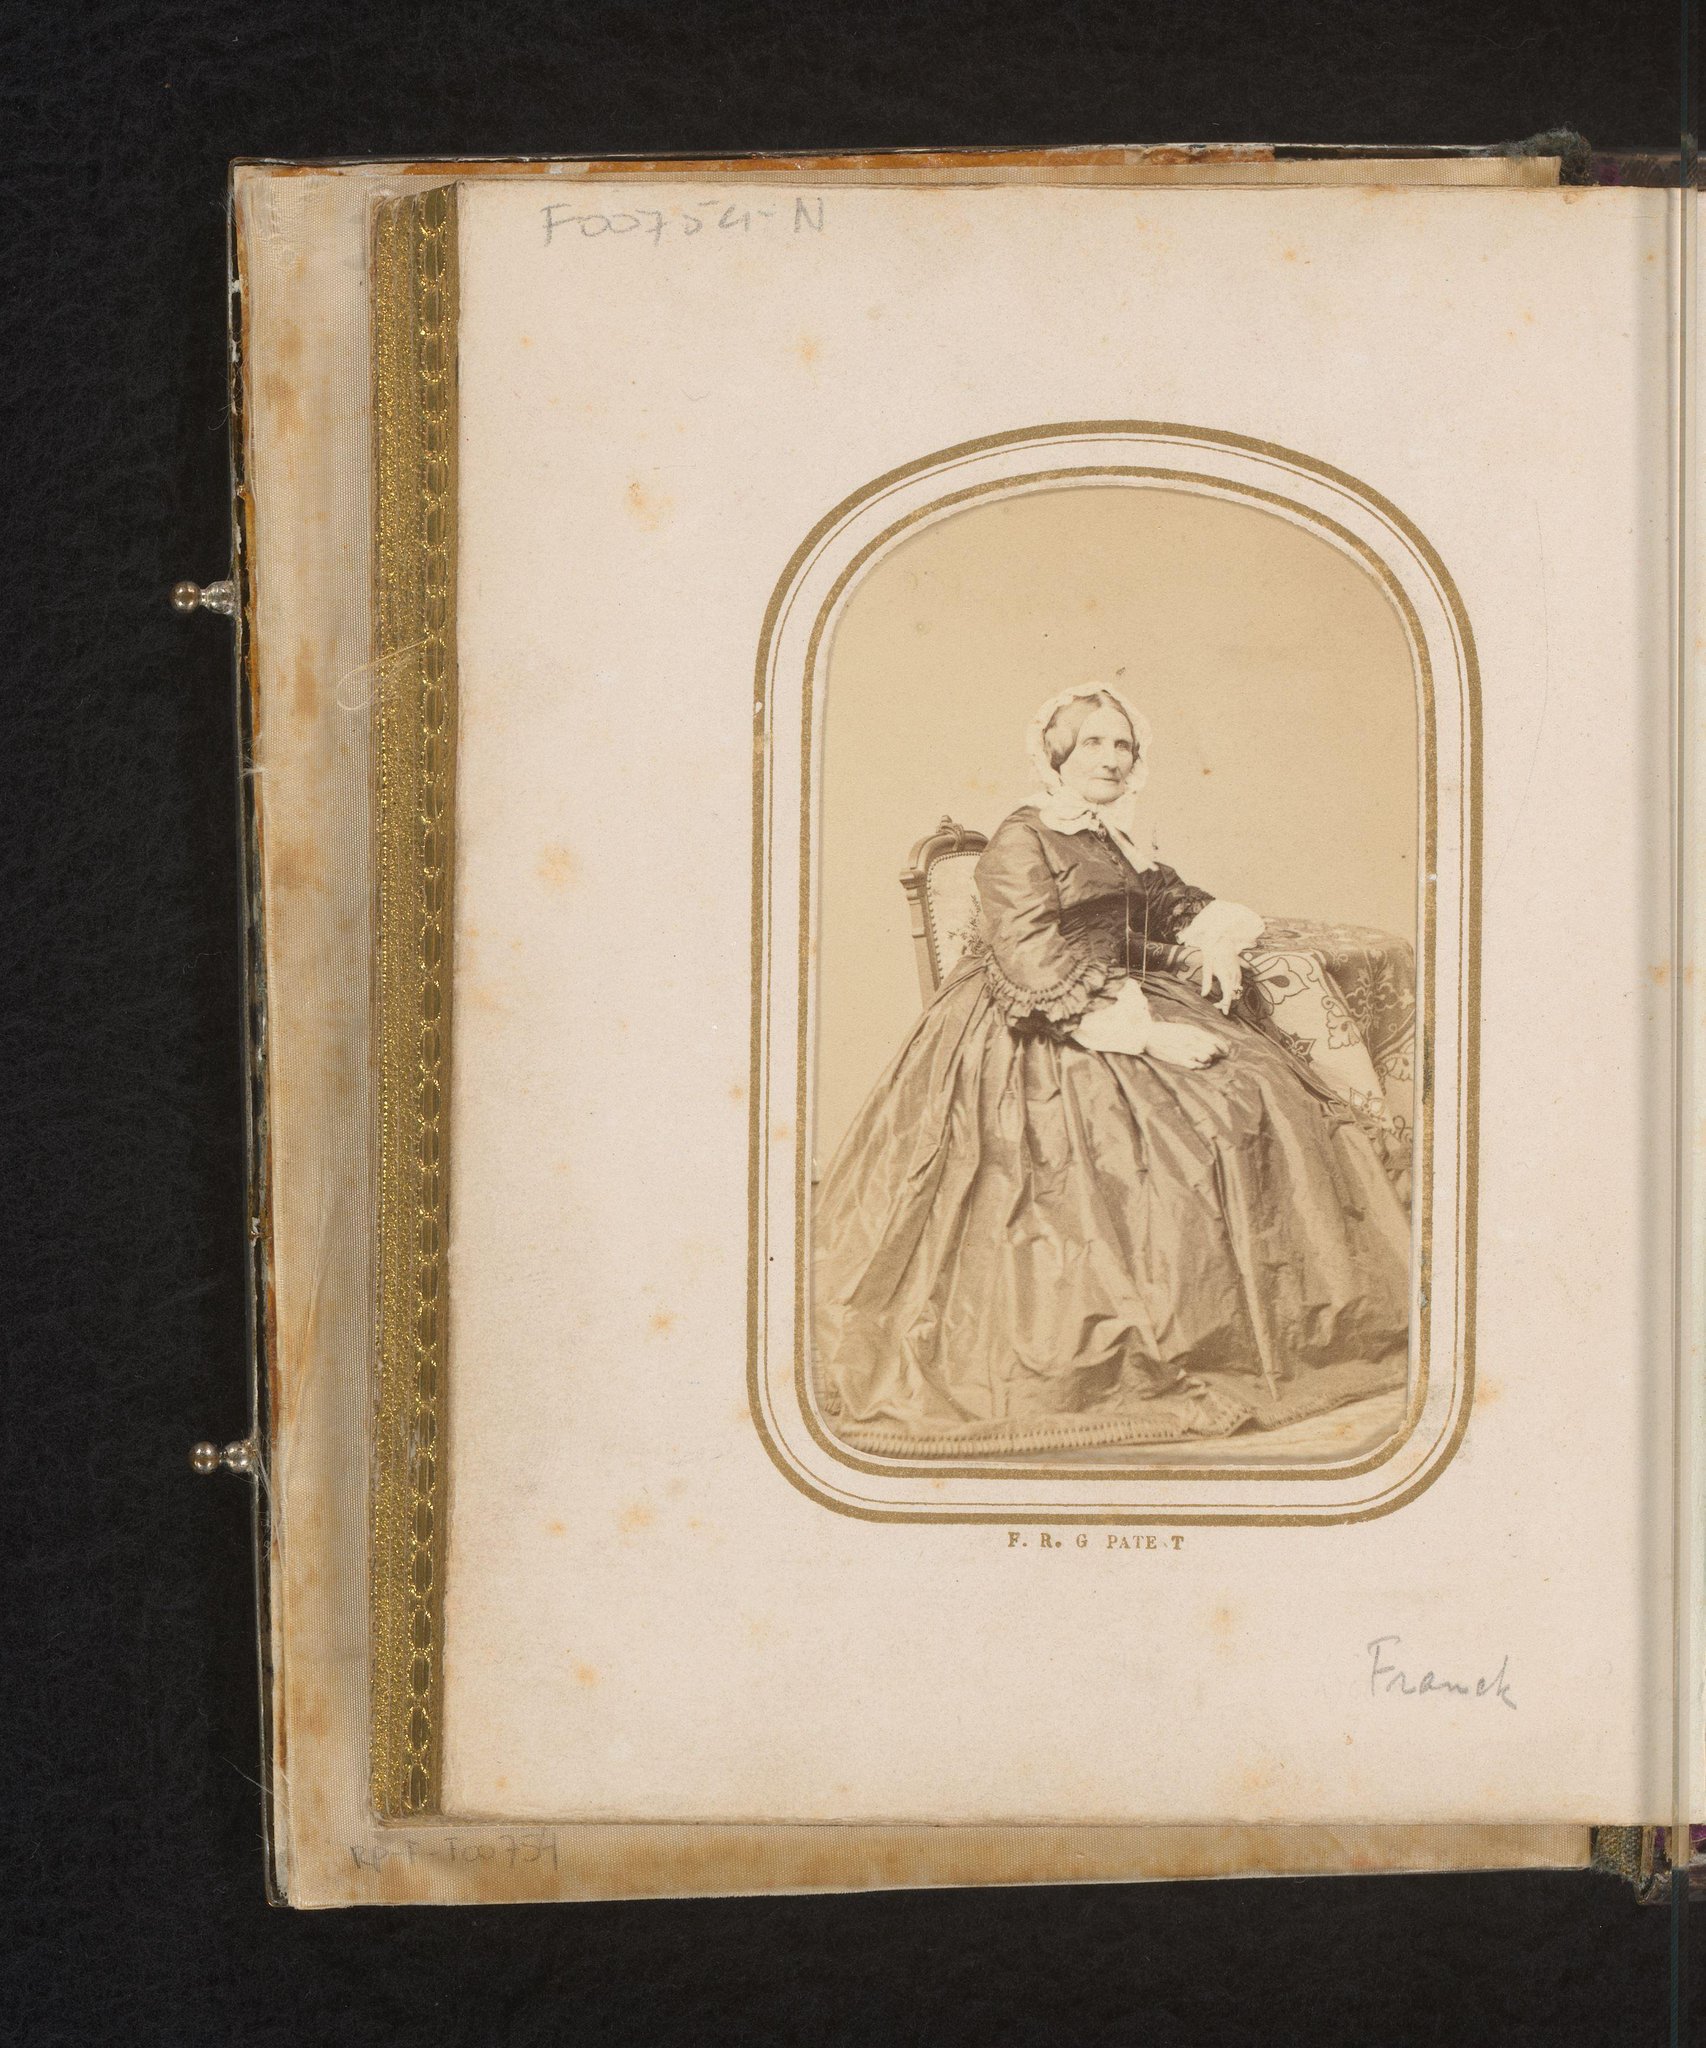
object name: album leaf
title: Portret van een zittende oude vrouw met muts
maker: françois marie louis franck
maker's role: fotograaf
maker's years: 1816-1906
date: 1855-1880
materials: cardboard, photographic support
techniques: albumen print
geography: france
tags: historical persons - bb - woman, head-gear: cap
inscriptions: inscription: ‘18 Rue Vivienne, succ.le 15 Place de la Bourse’